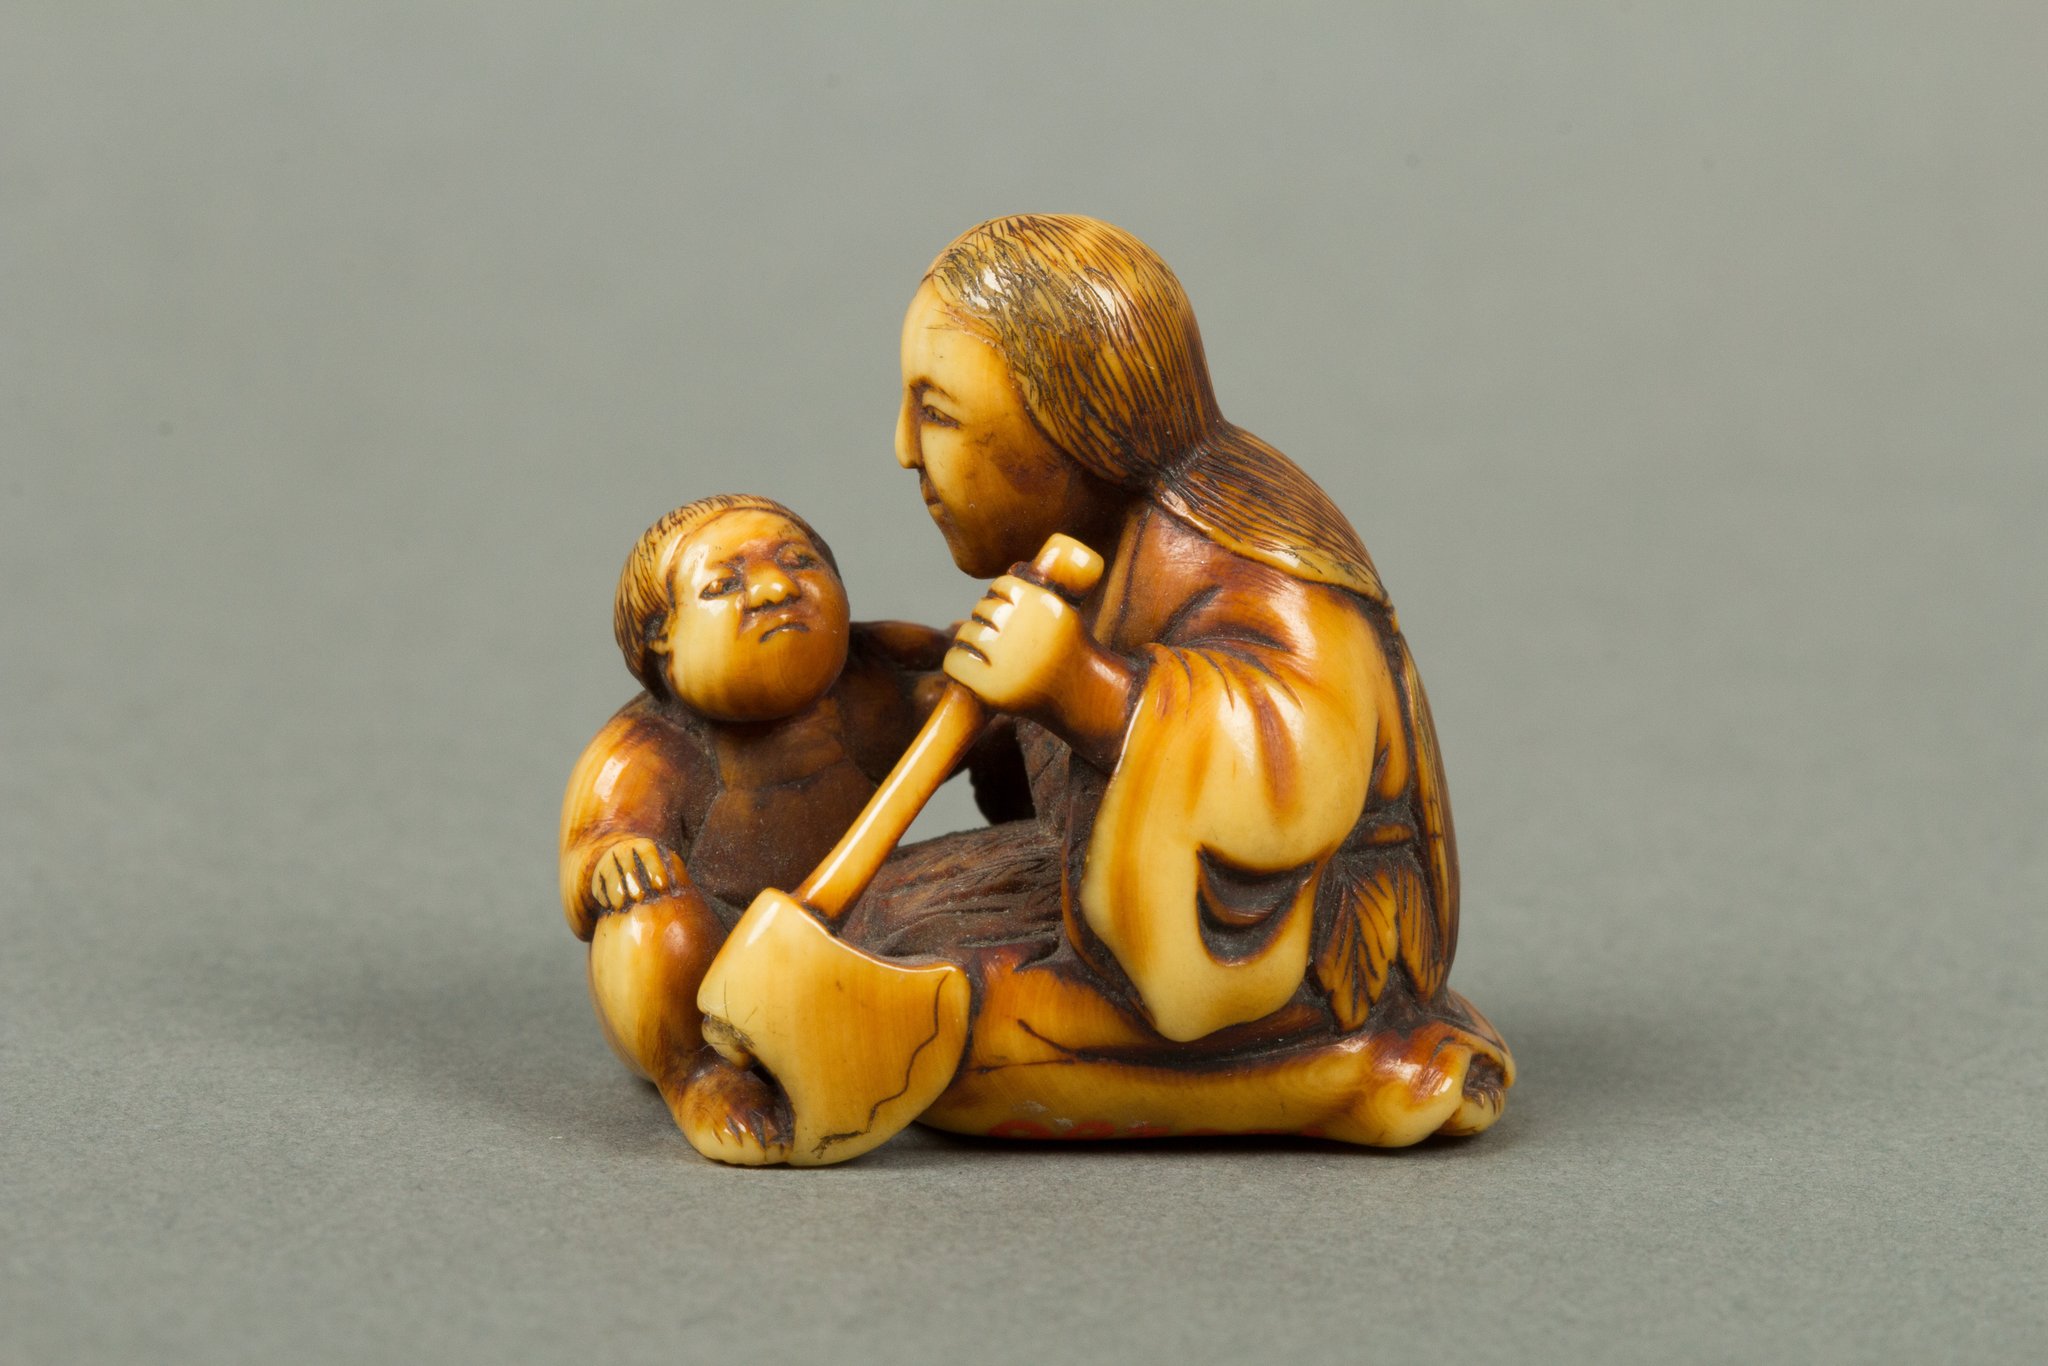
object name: netsuke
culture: japanese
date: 1801-1900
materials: ivory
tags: children,women,axes